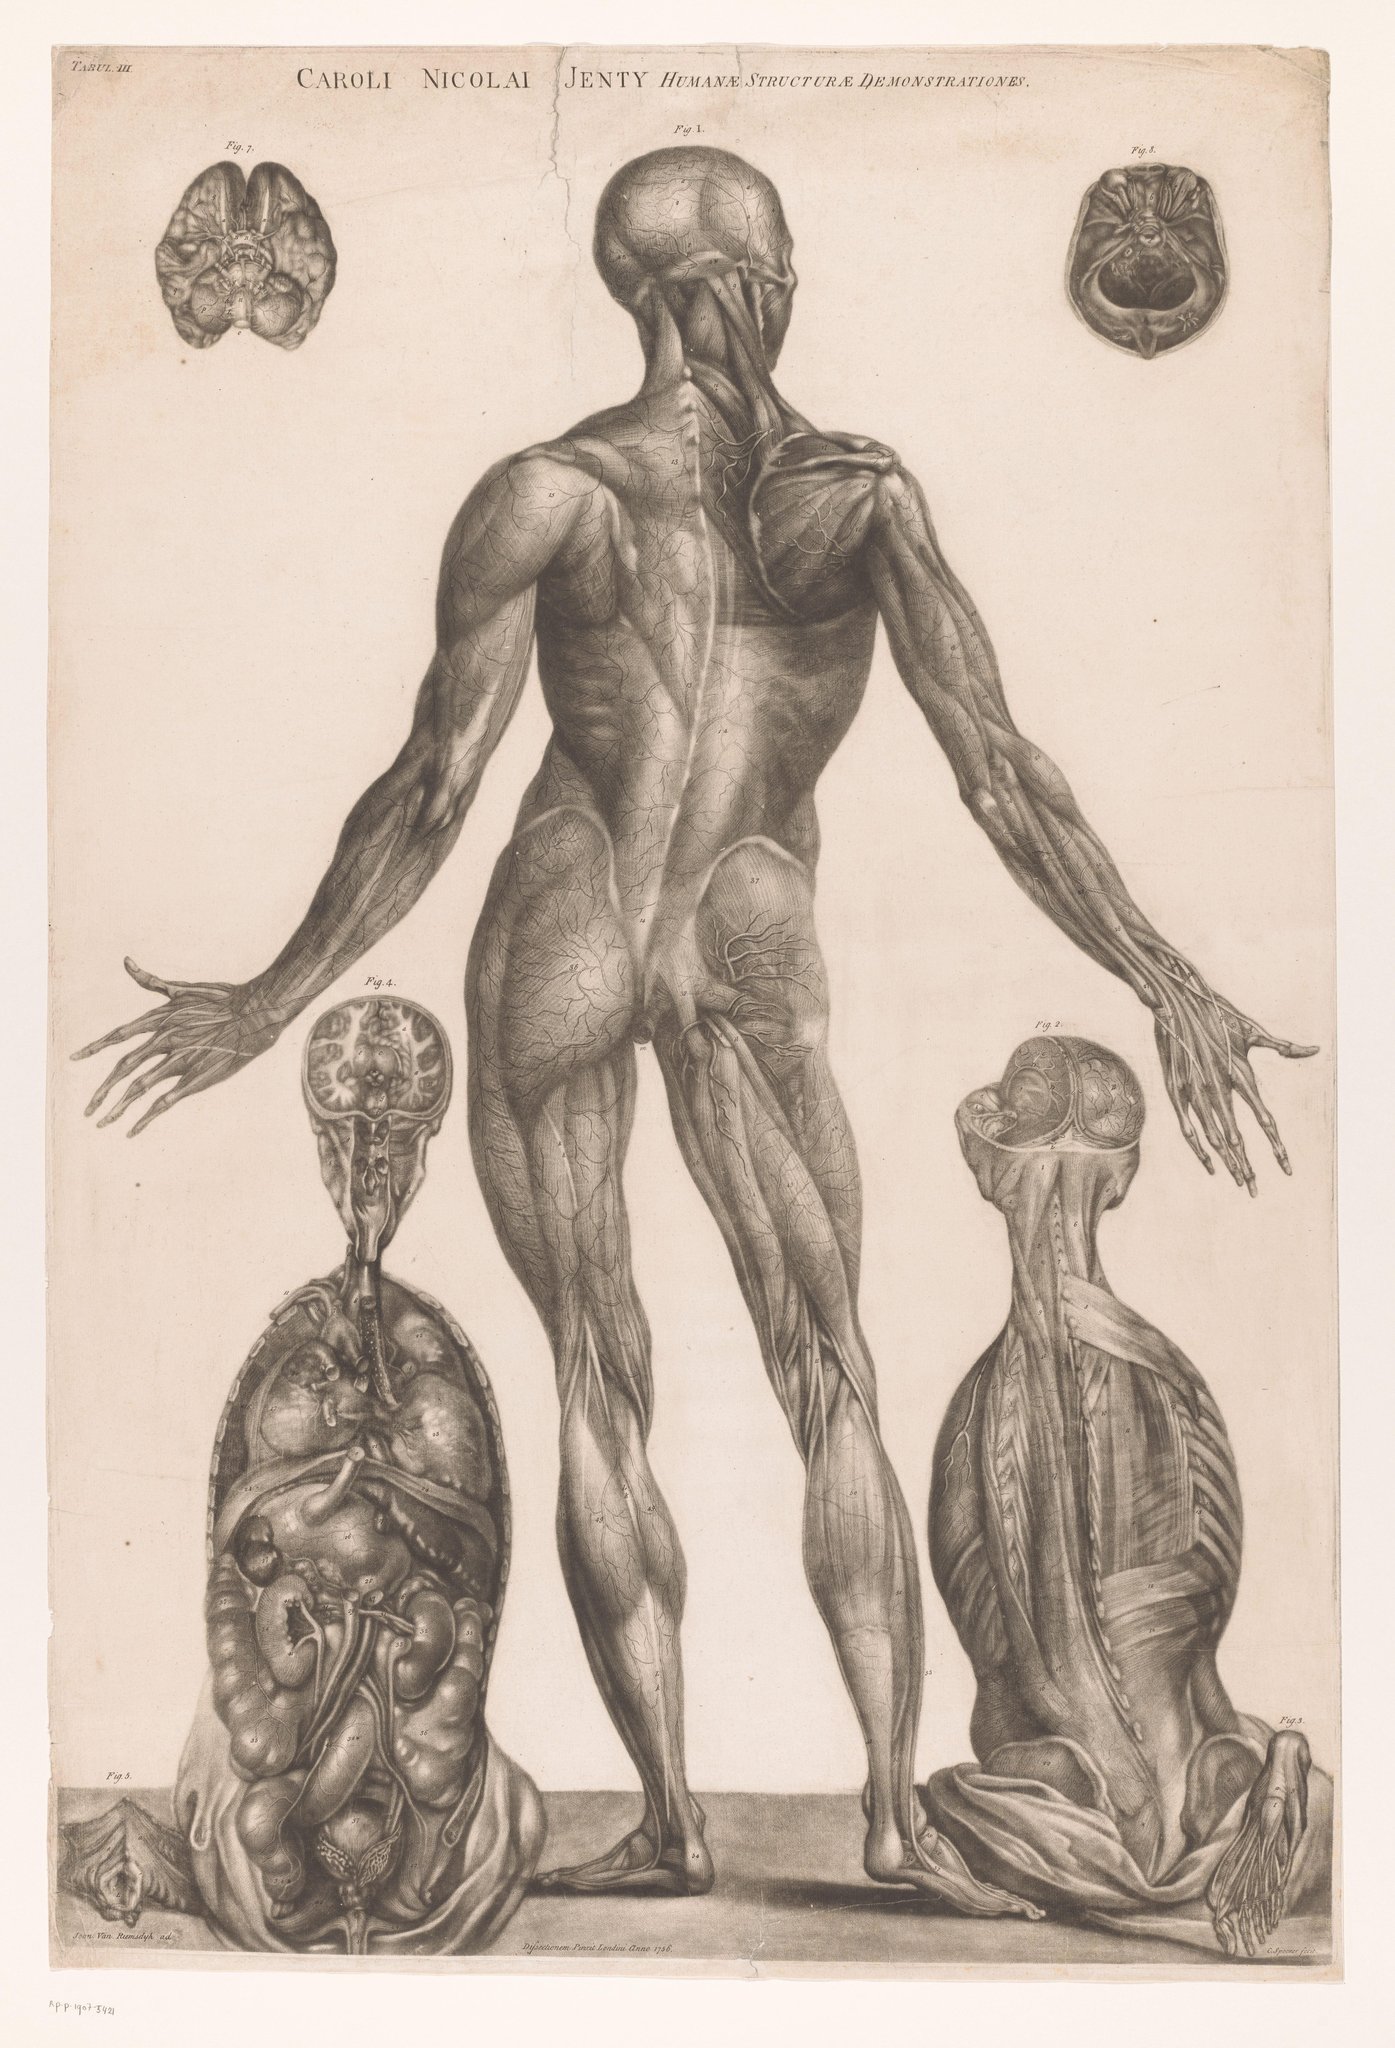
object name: print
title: Anatomische studie van de achterzijde van het lichaam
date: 1756-1767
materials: paper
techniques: mezzotint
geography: london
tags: parts of the human body (skeleton excepted), anatomical model of the muscles, muscle-man, 'écorché'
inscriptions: collector's mark: Lugt 2228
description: Met nummering van onderdelen. Linksboven: Tabul. III.